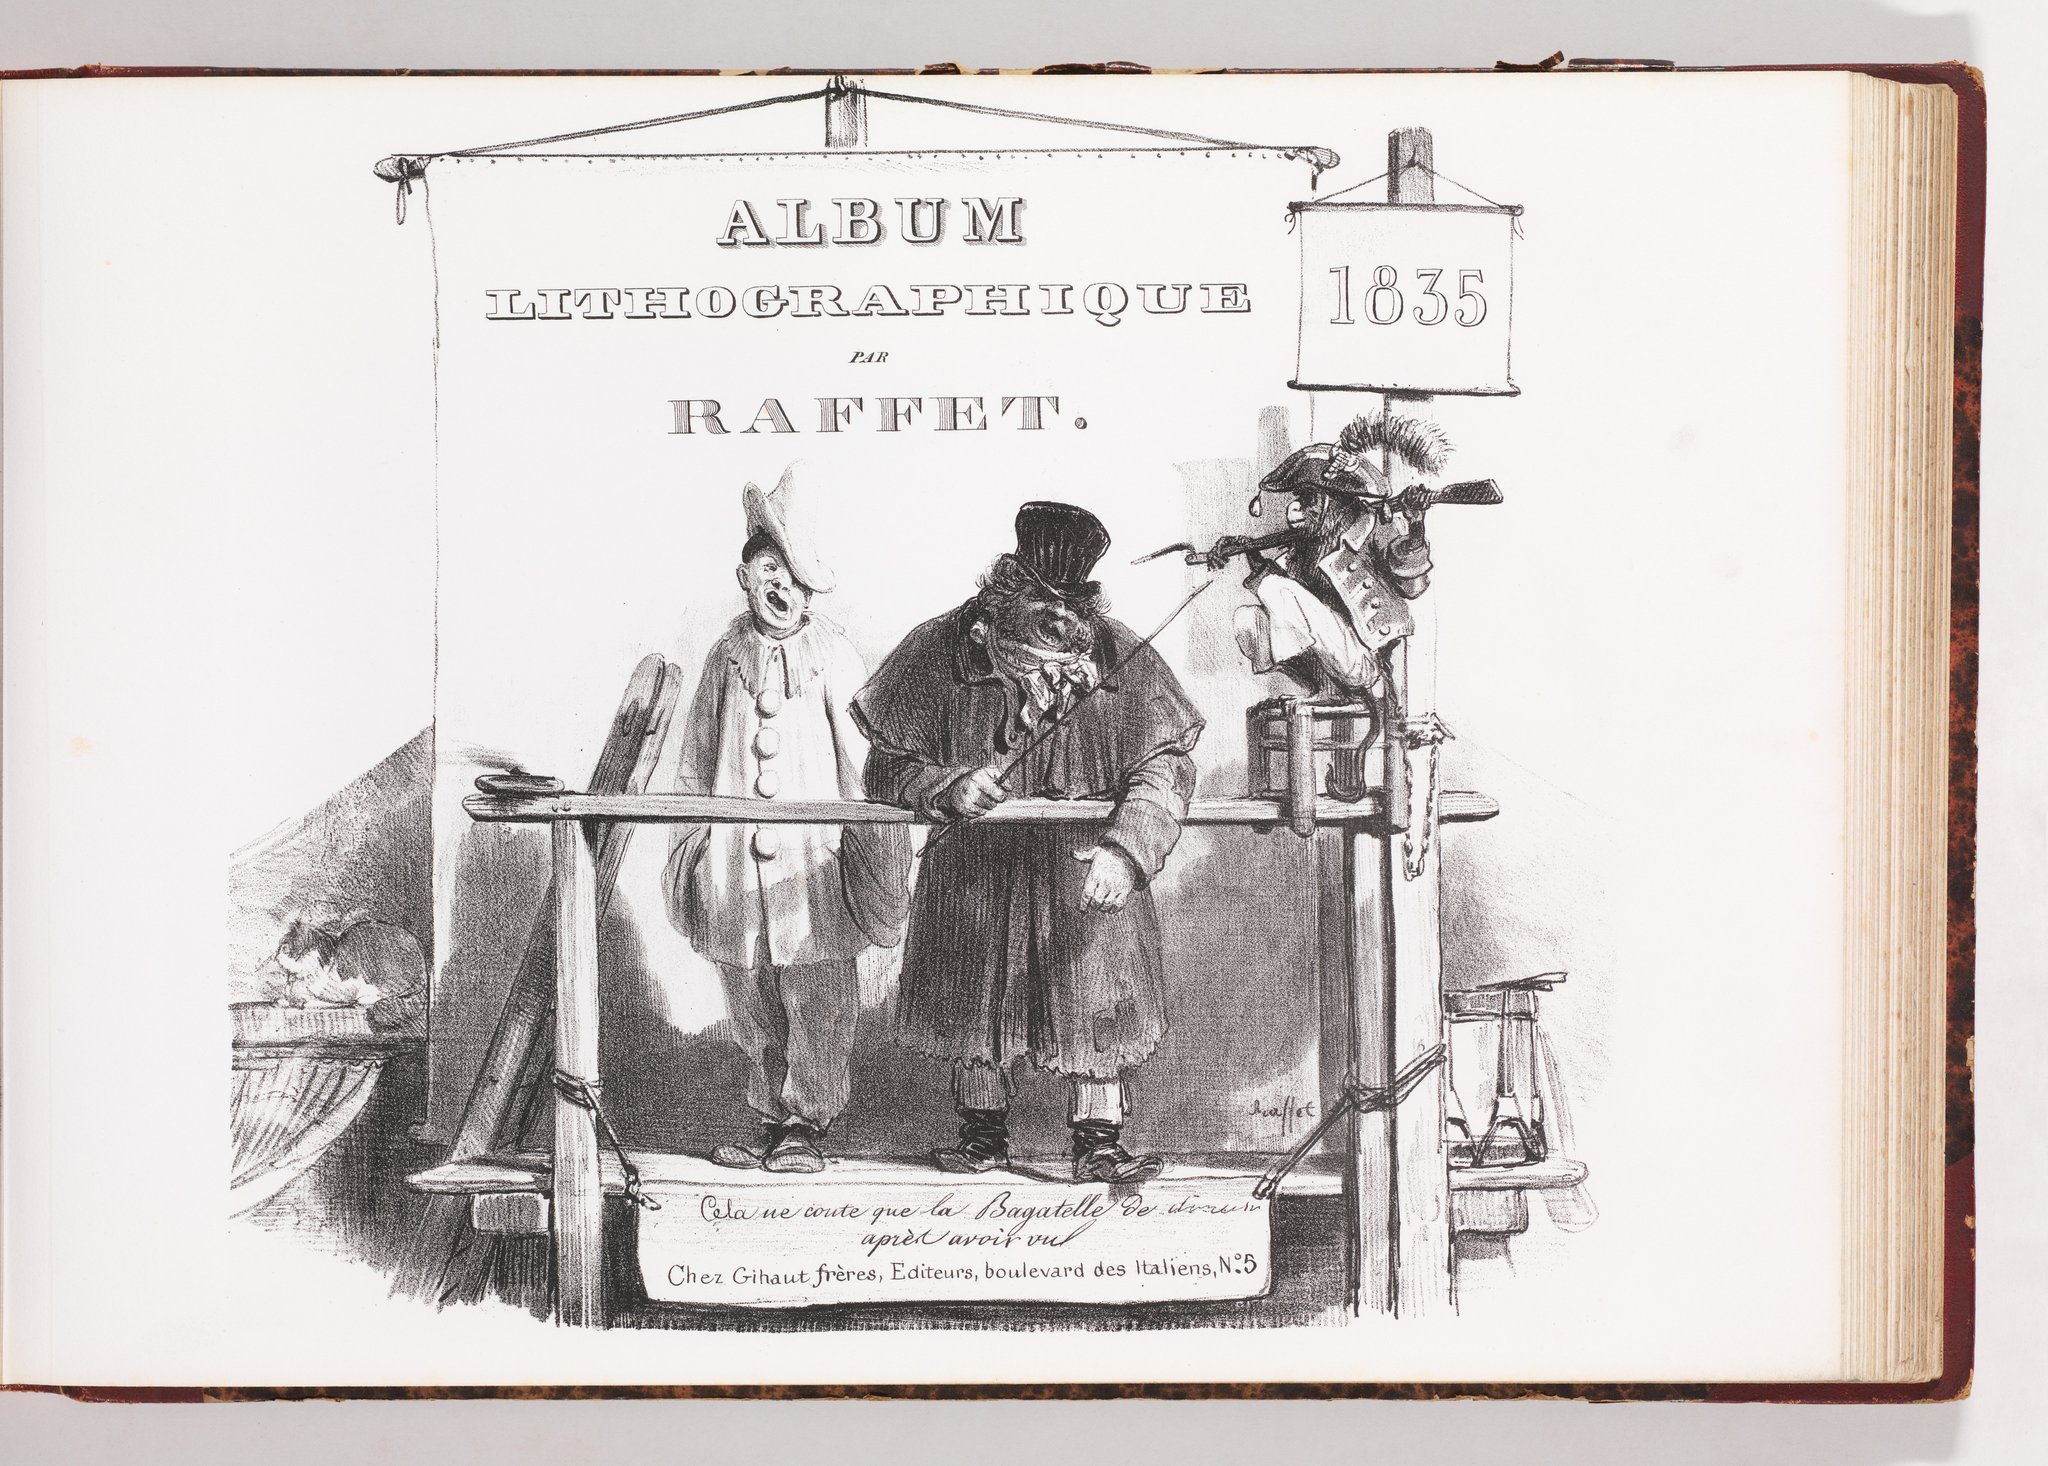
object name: book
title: Album Lithographique 1830-1837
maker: auguste raffet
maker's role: artist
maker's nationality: french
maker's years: 1804-1860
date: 1830-1837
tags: men